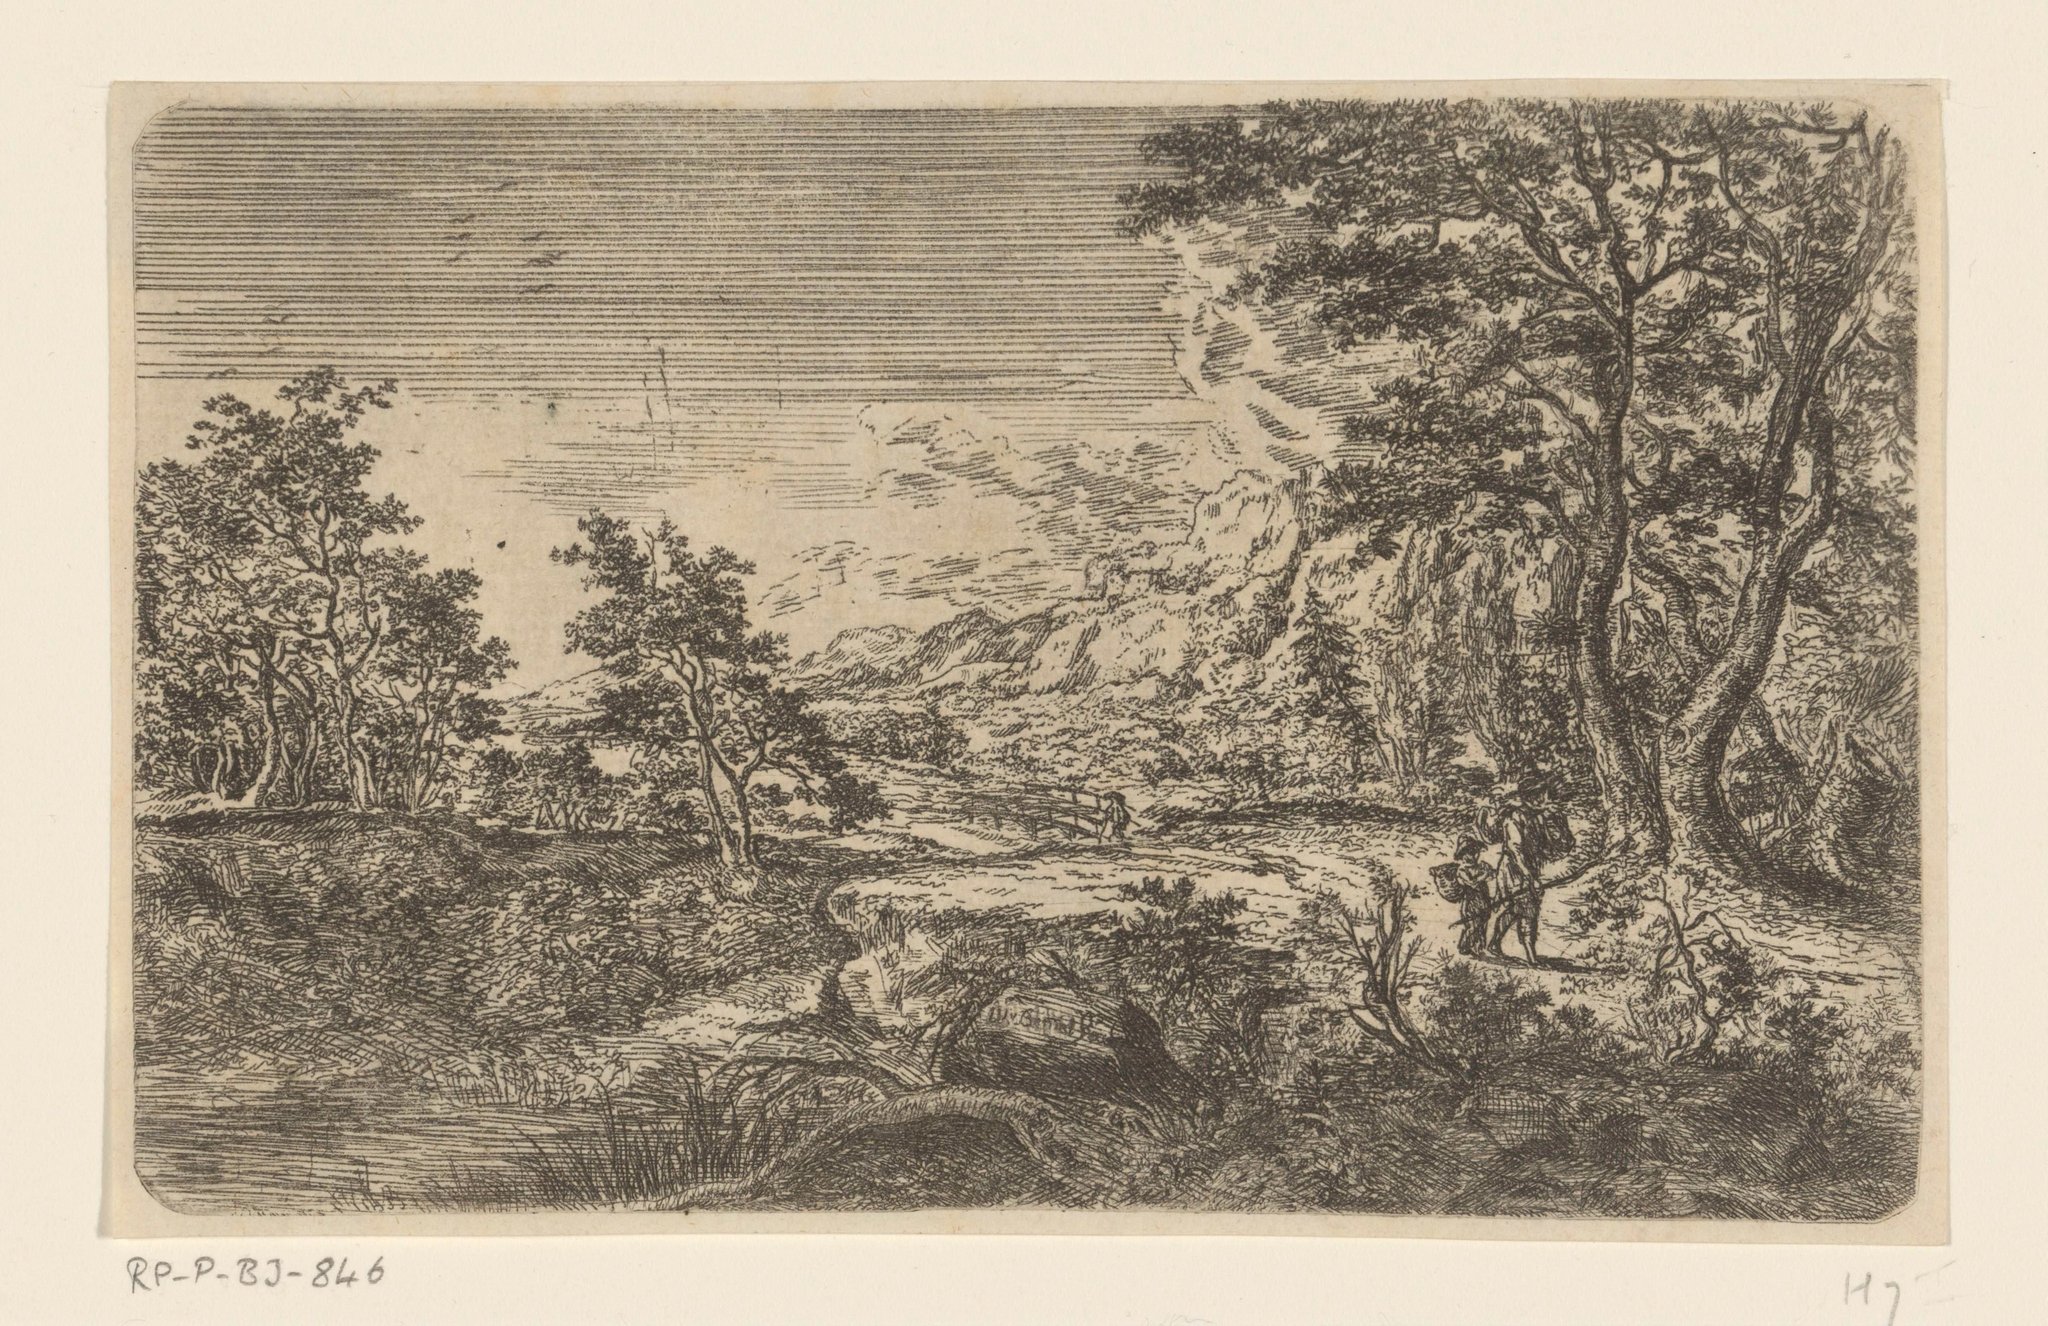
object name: print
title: Landschap met man en jongetje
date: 1755-1814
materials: paper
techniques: etching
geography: germany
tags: landscapes in the temperate zone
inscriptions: collector's mark: Lugt 2228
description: Deze prent is een imitatie van Willem van Bemmel door Bartholomäus Ignaz Weiss.